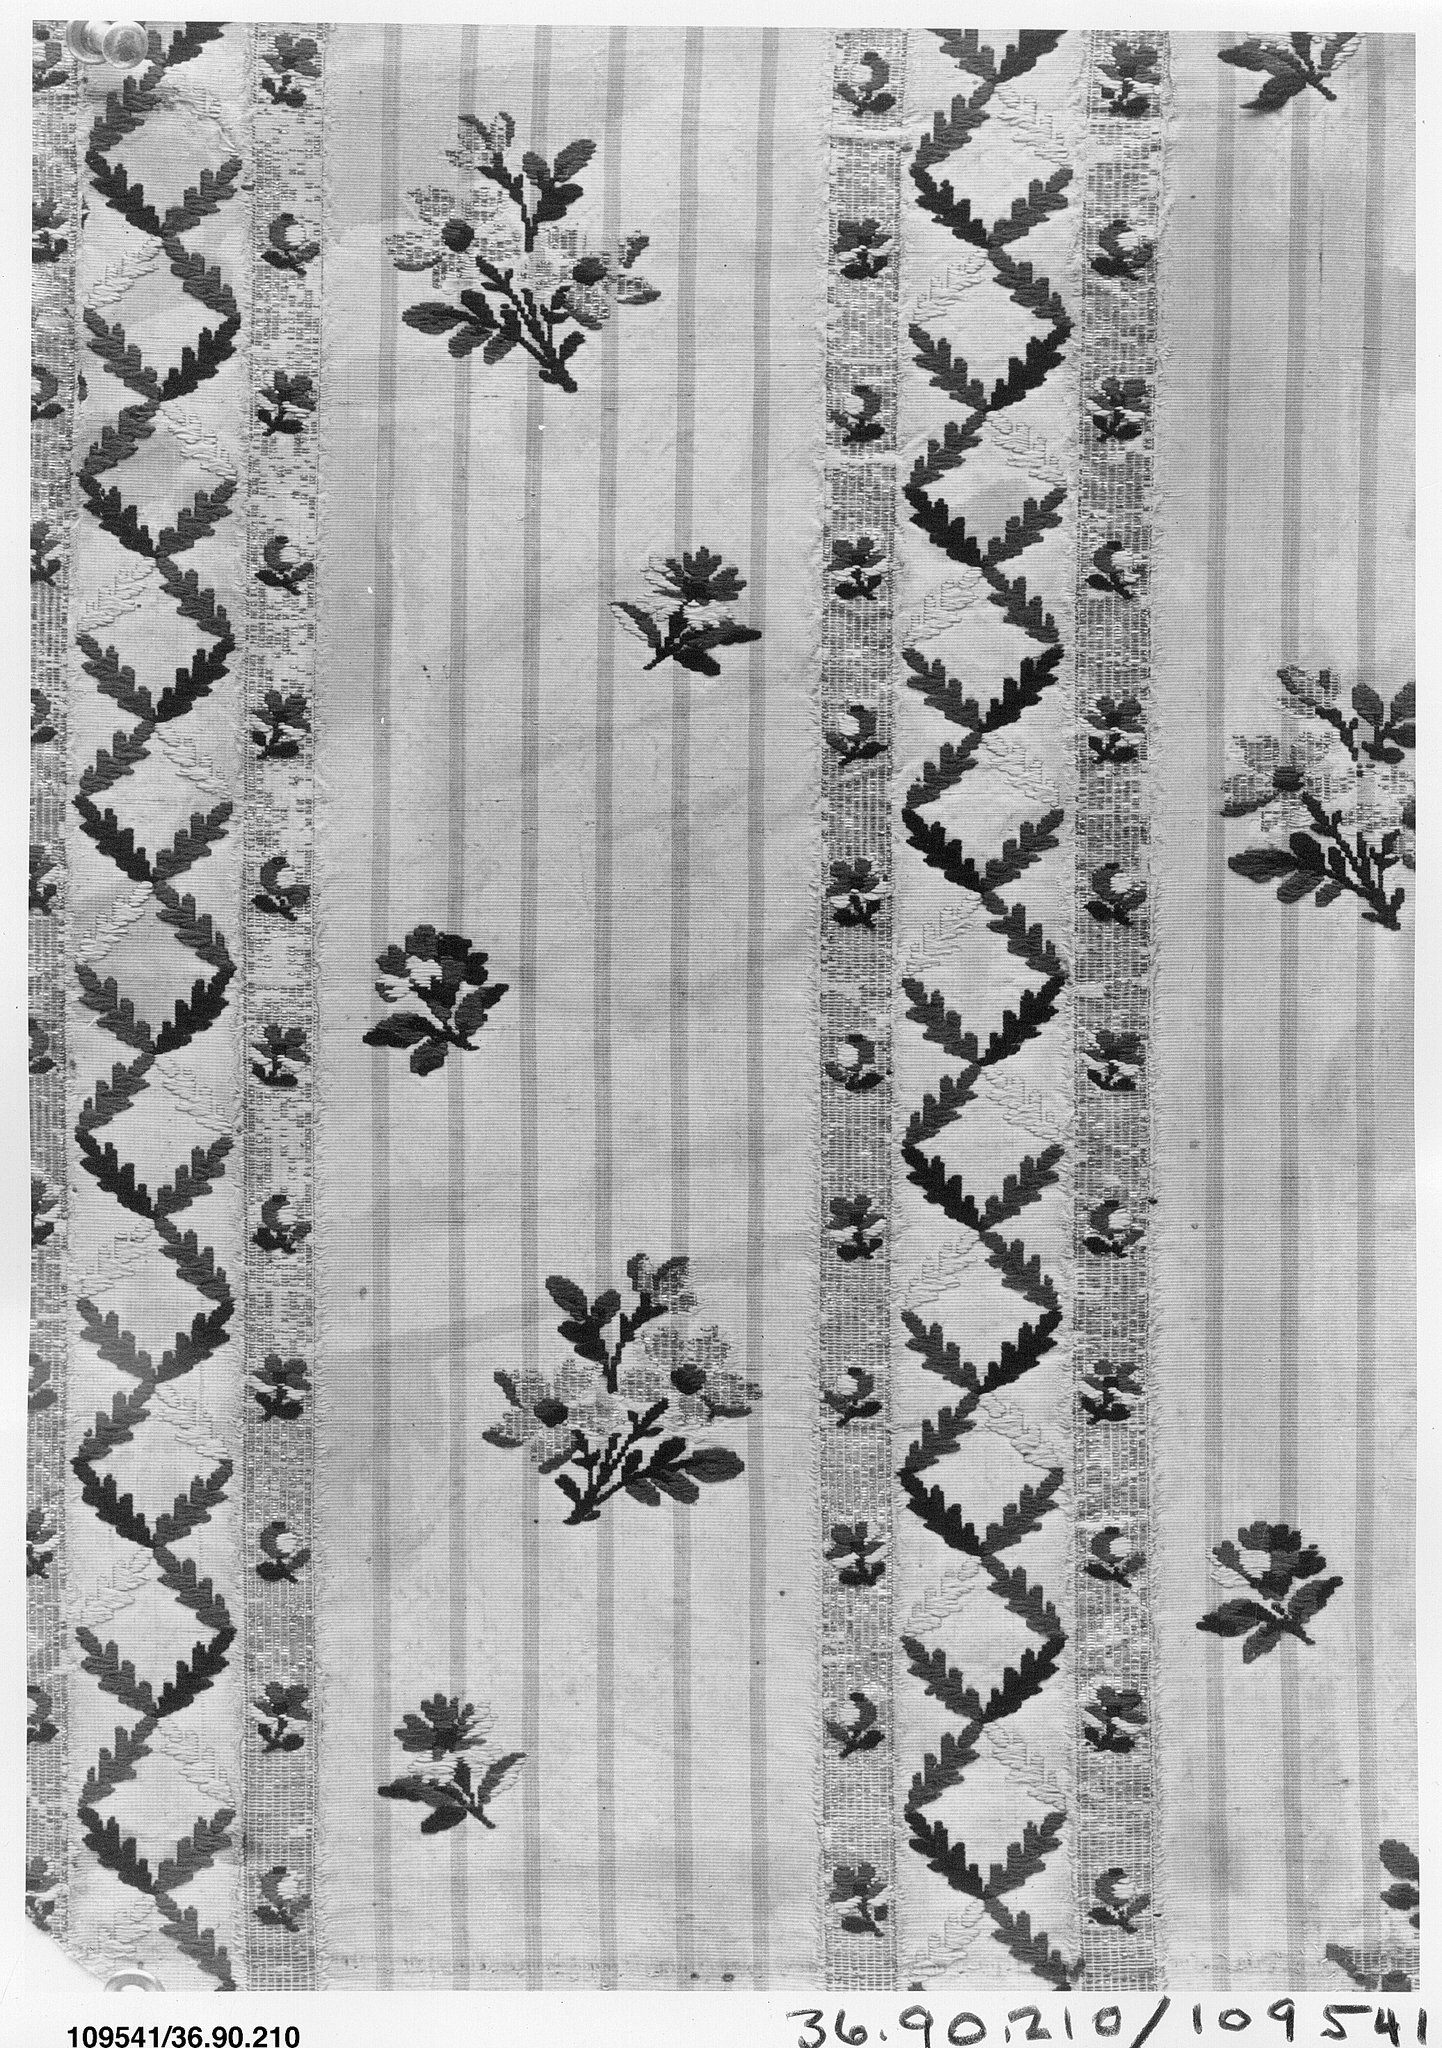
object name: piece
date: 1701-1800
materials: metal thread, silk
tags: flowers,leaves